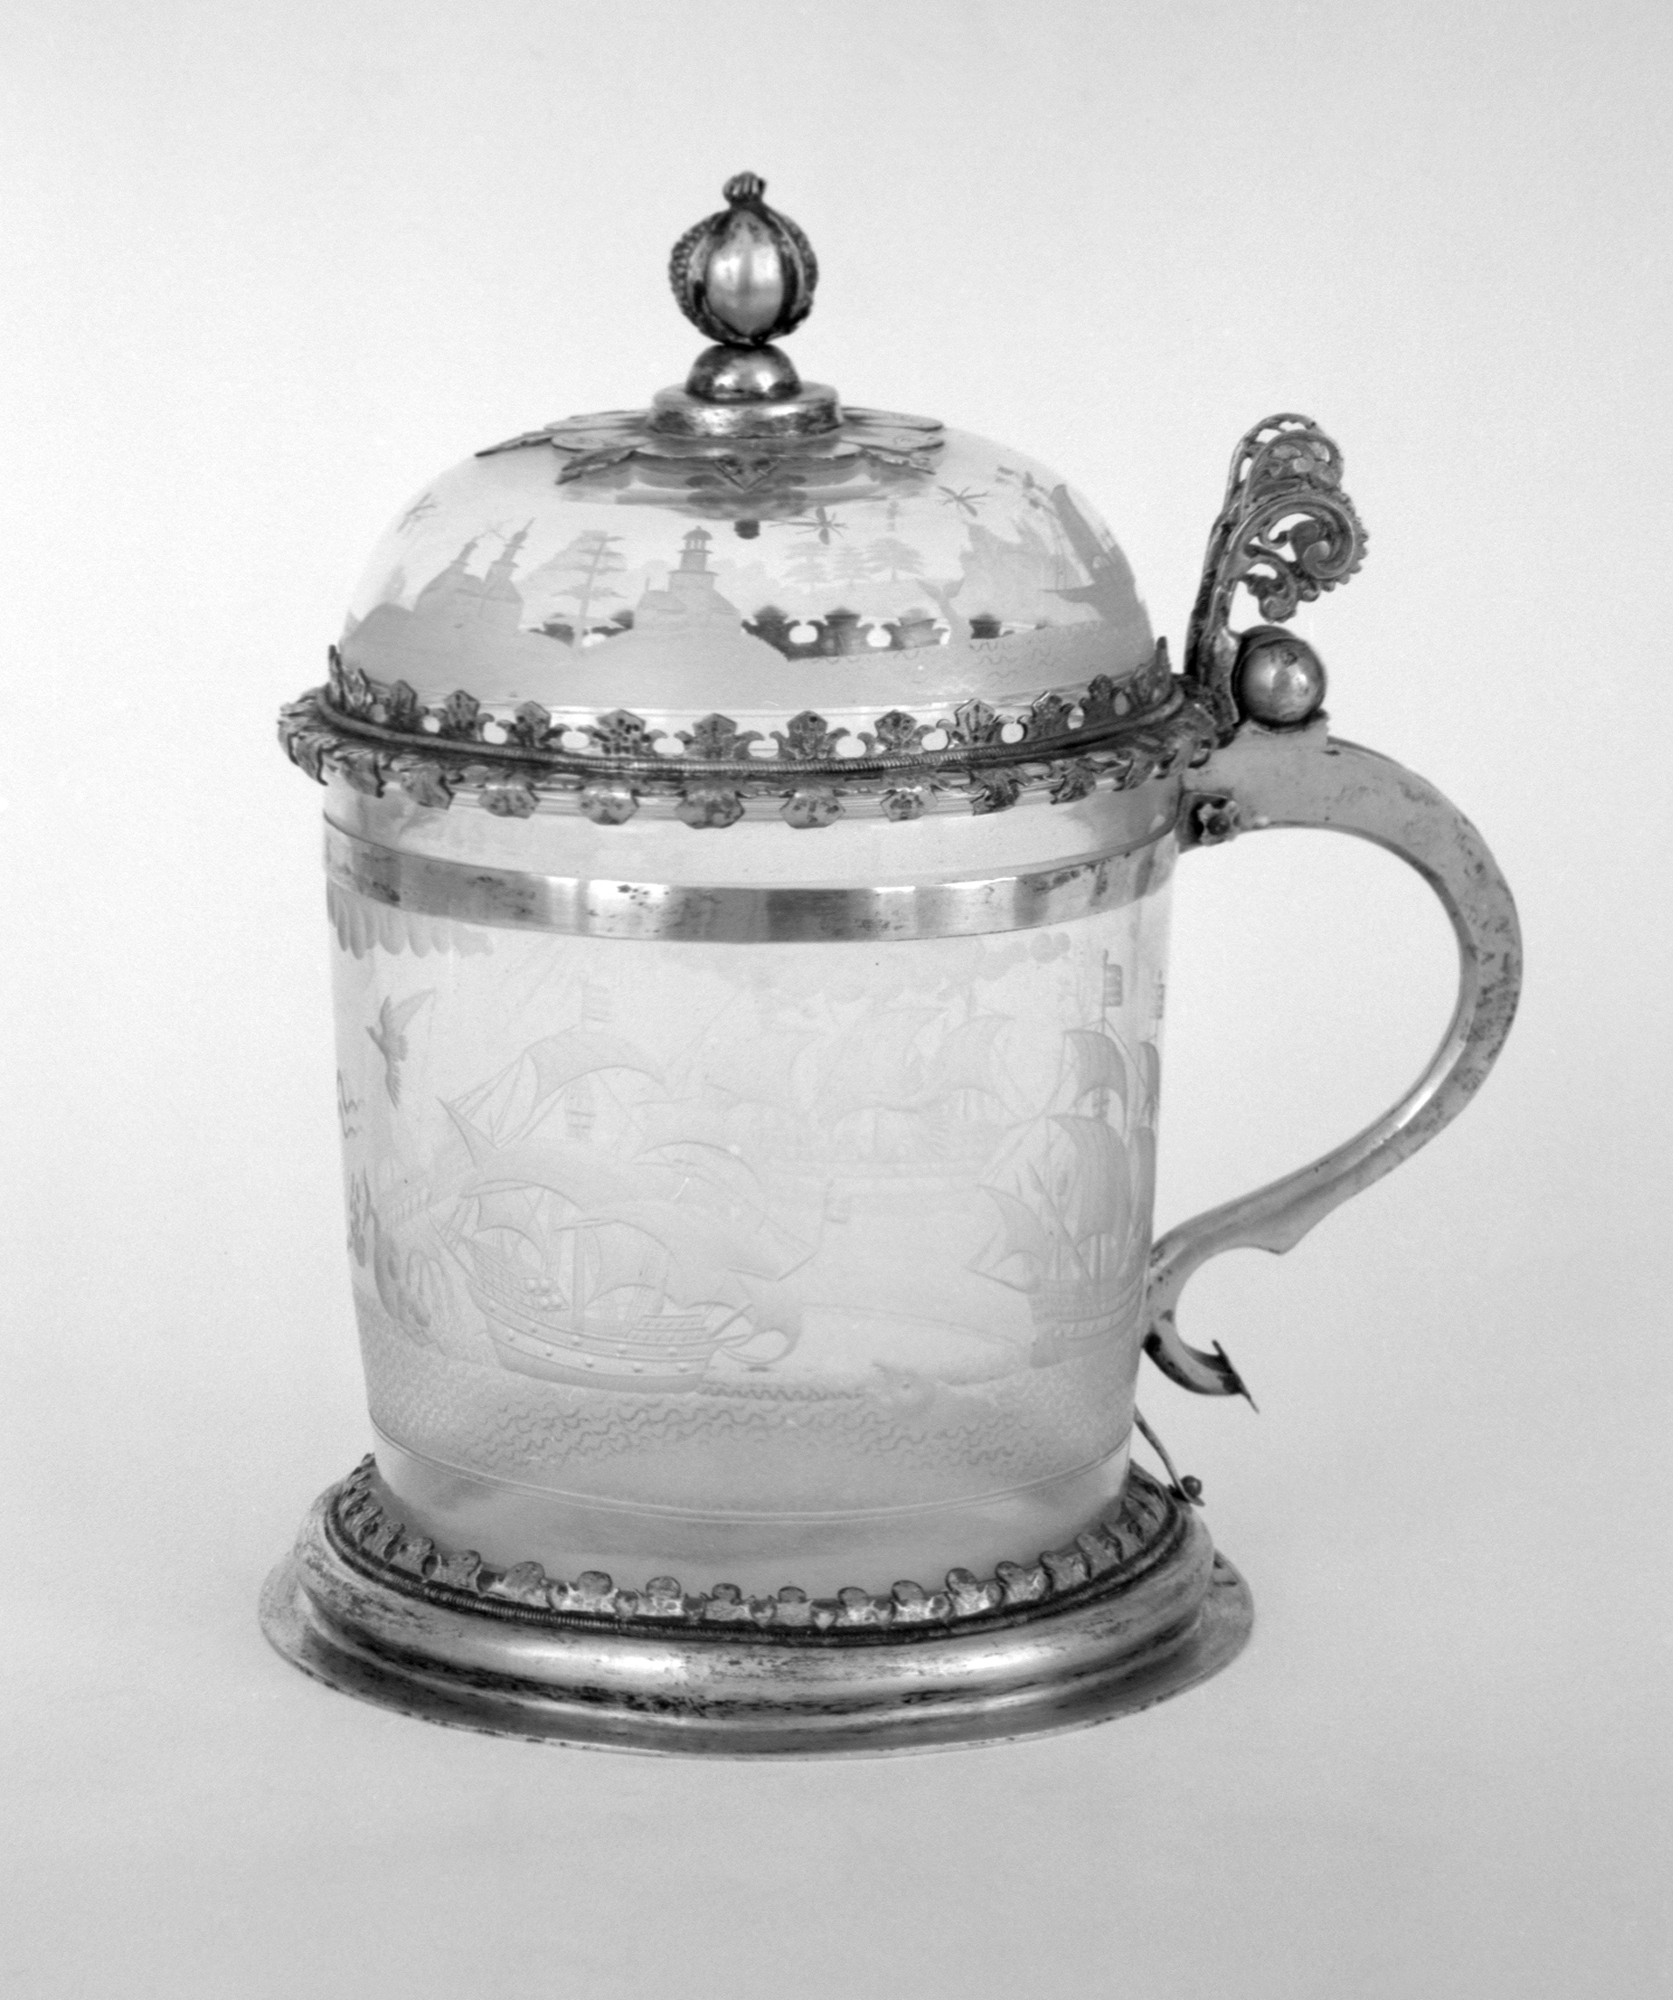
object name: tankard with cover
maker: georg schwanhardt the elder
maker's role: engraver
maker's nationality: german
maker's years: 1601-1667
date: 1801-1900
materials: glass, silver gilt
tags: birds,ships